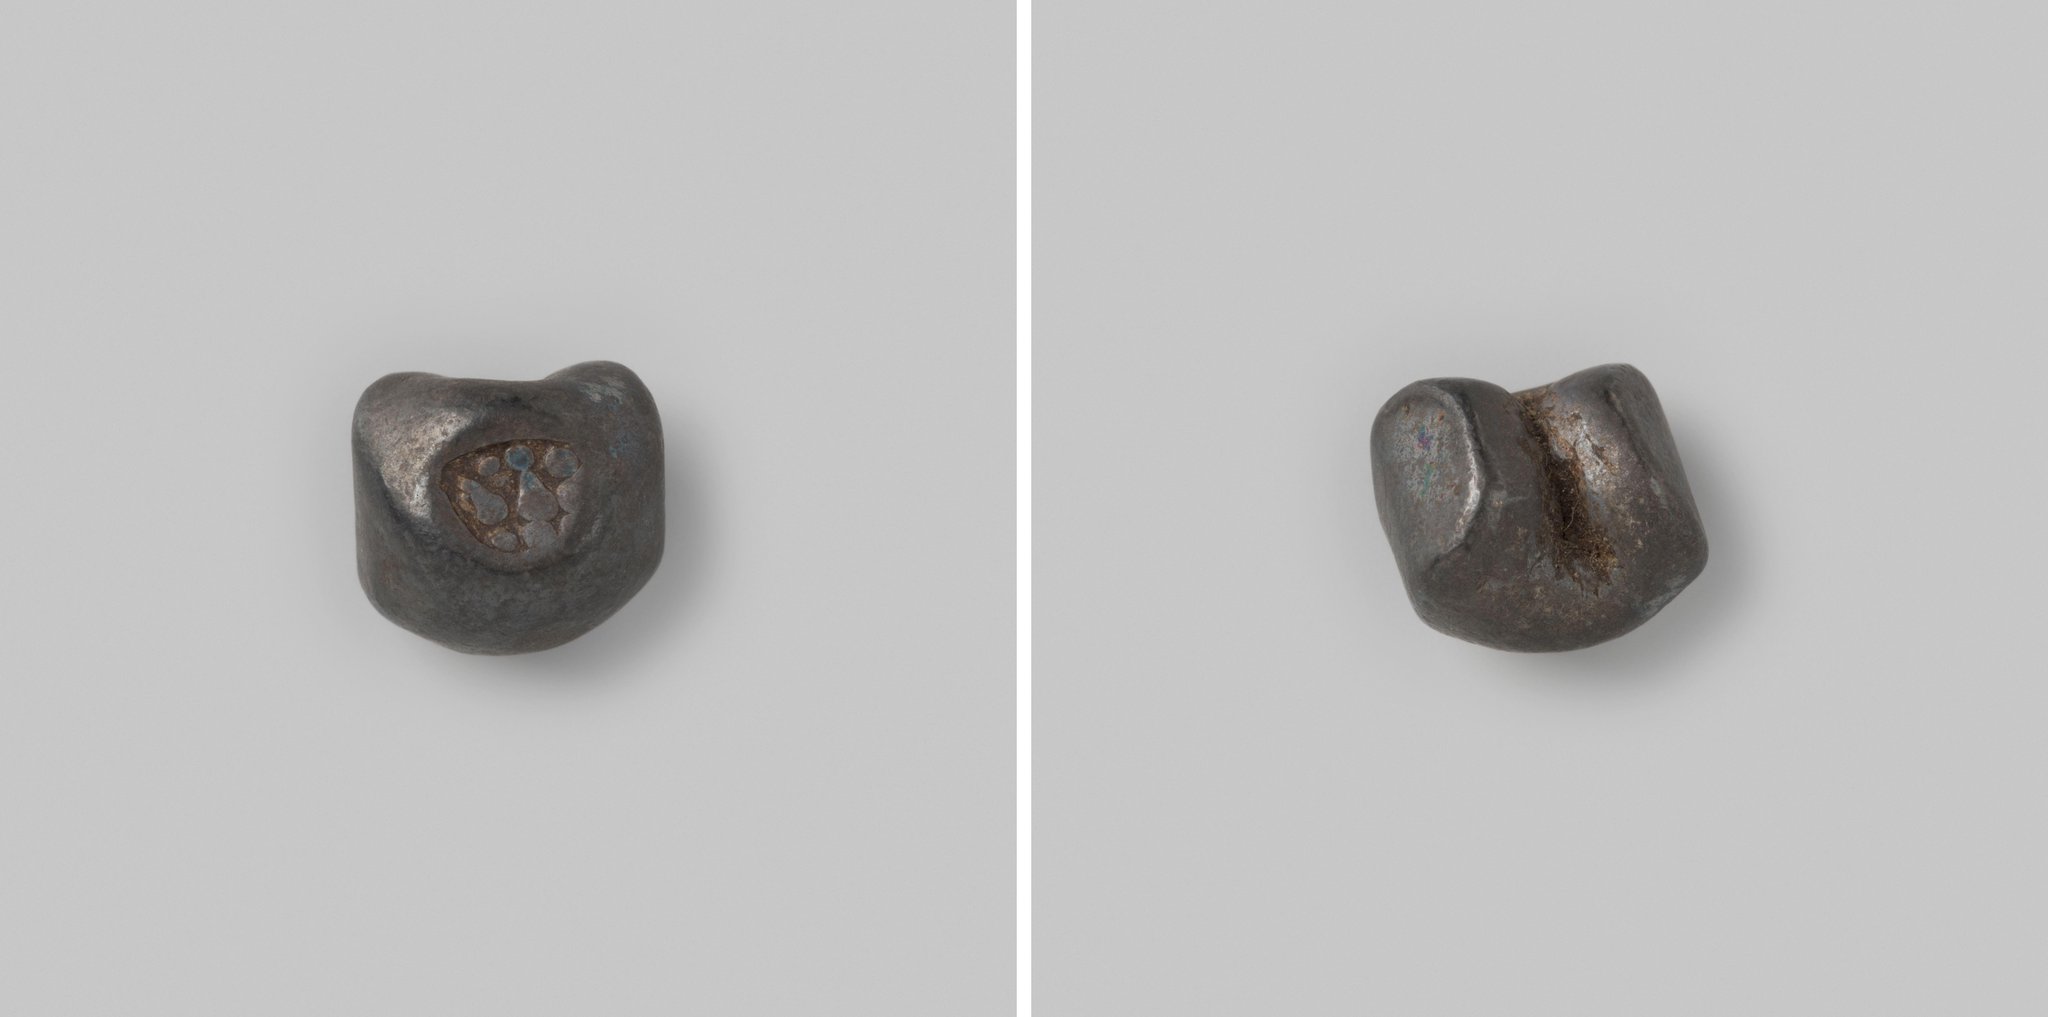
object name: coin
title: 1/4 tical of salung uit Birma van Maha Mongkut, 1851-1866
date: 1851-1866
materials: silver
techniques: casting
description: Zilveren, korrelvormige munt. voorzien van één instempeling (kra): vishaak